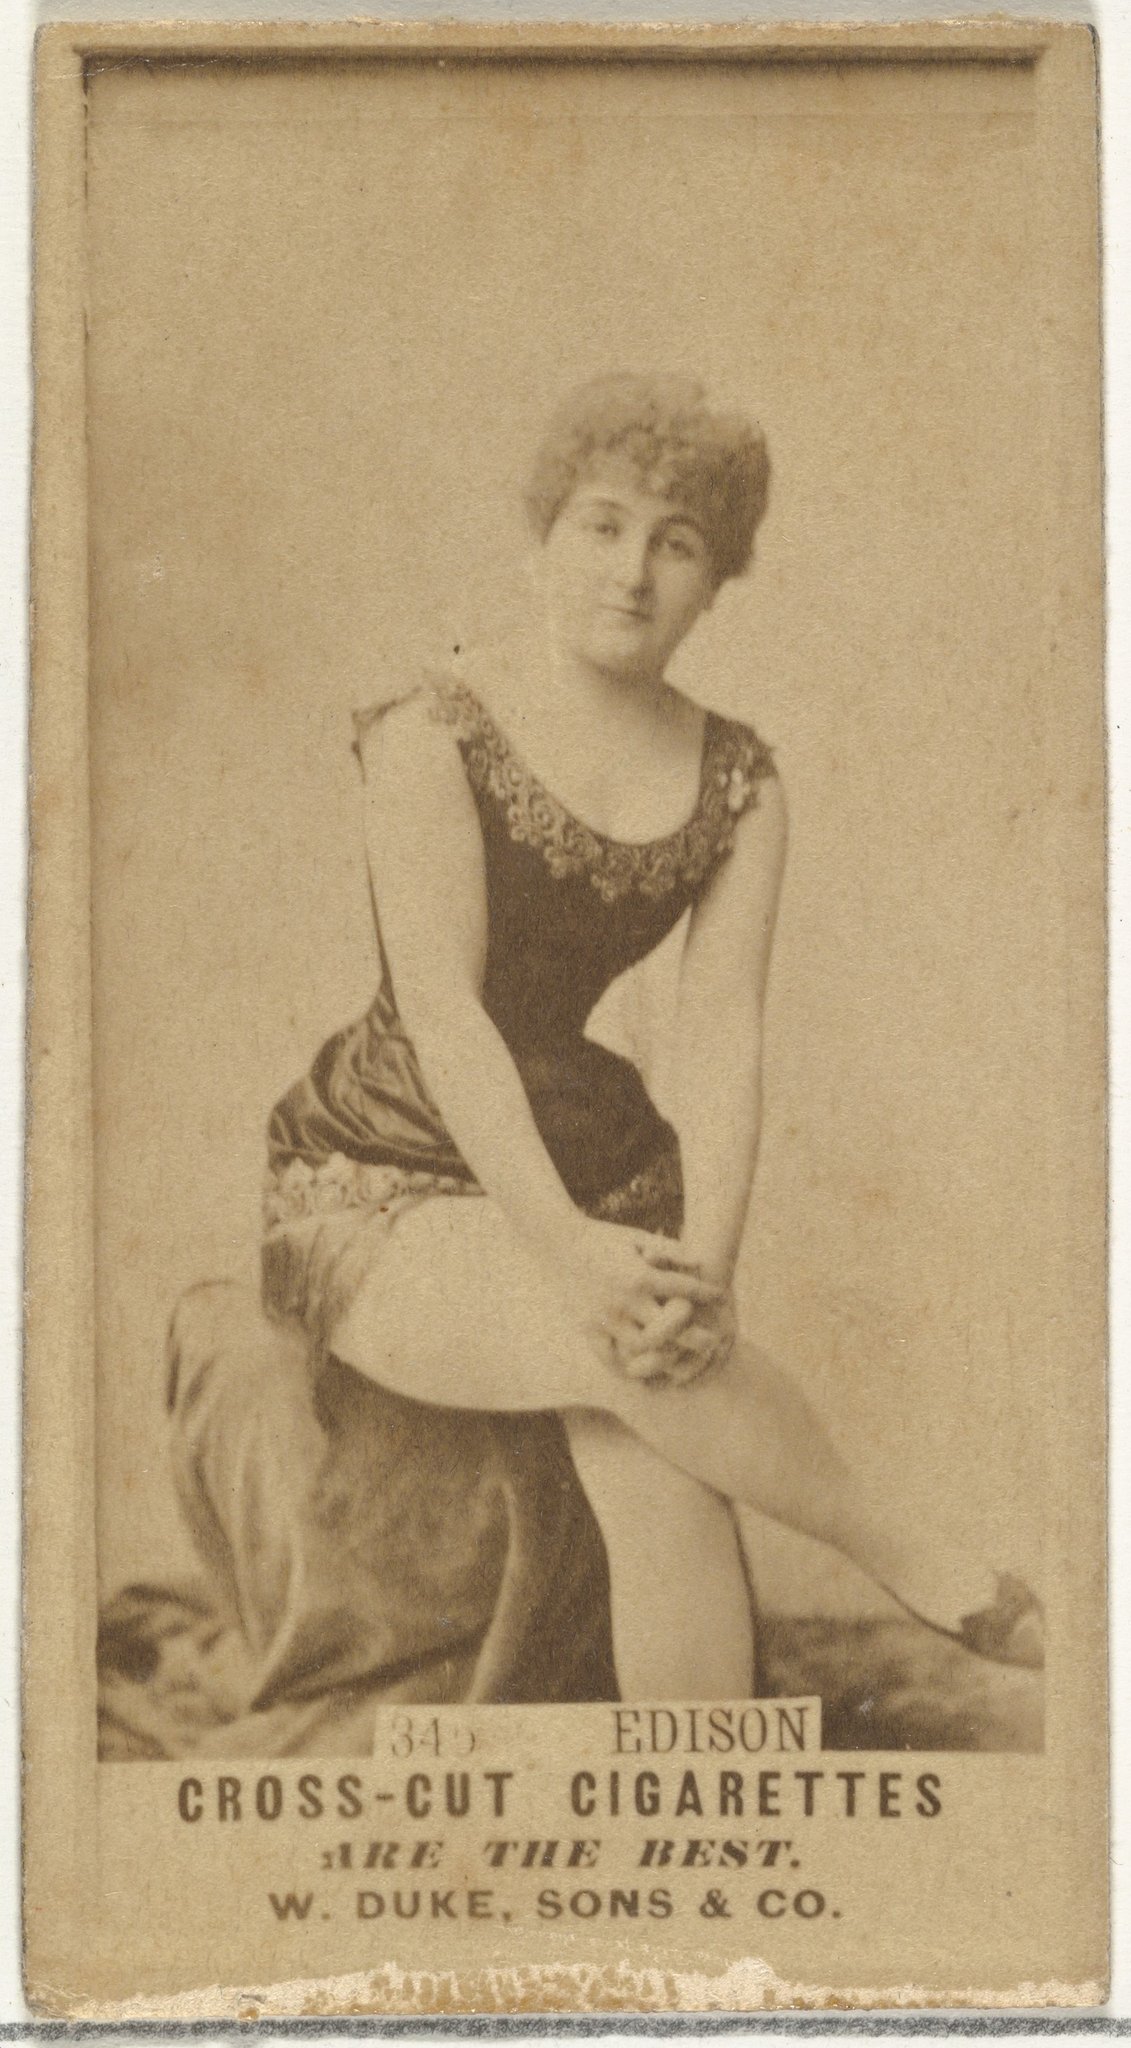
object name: photograph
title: Edison, from the Actors and Actresses series (N145-3) issued by Duke Sons & Co. to promote Cross Cut Cigarettes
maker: w. duke, sons & co.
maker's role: publisher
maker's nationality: american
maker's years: 1870-1920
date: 1880-1889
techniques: albumen silver print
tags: portraits,women,actresses